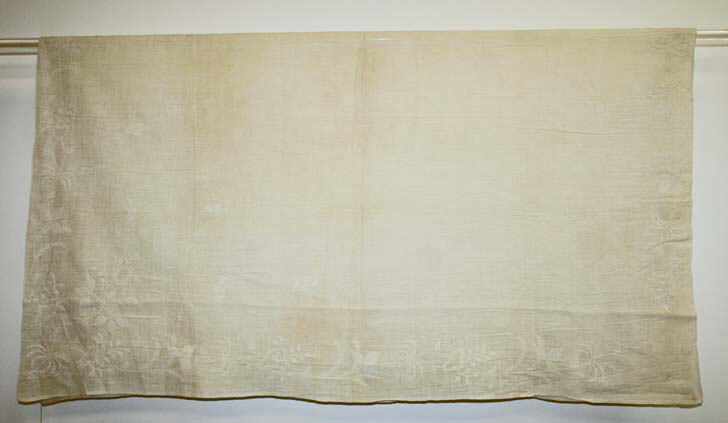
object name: fichu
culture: american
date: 1801-1833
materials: cotton